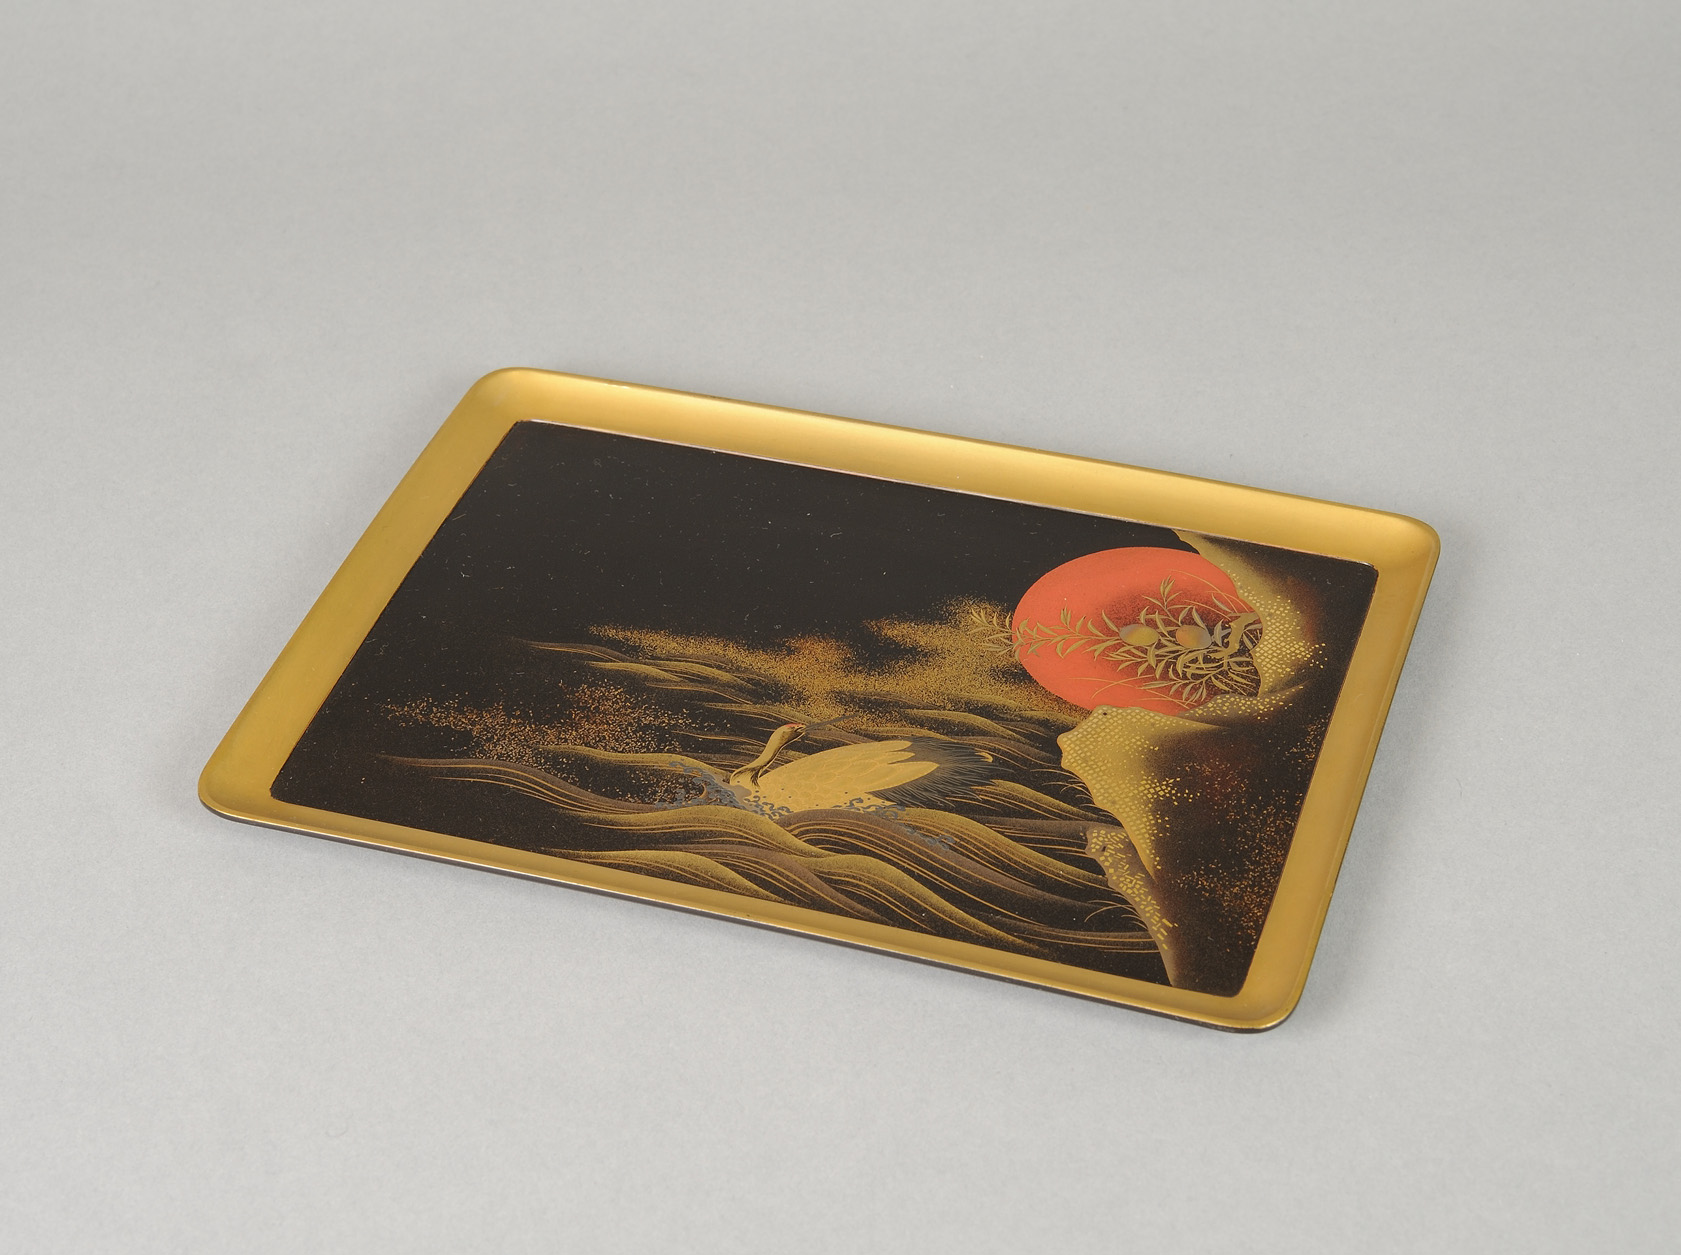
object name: tray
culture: japanese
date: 1801-1900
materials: lacquer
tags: birds,moon,leaves